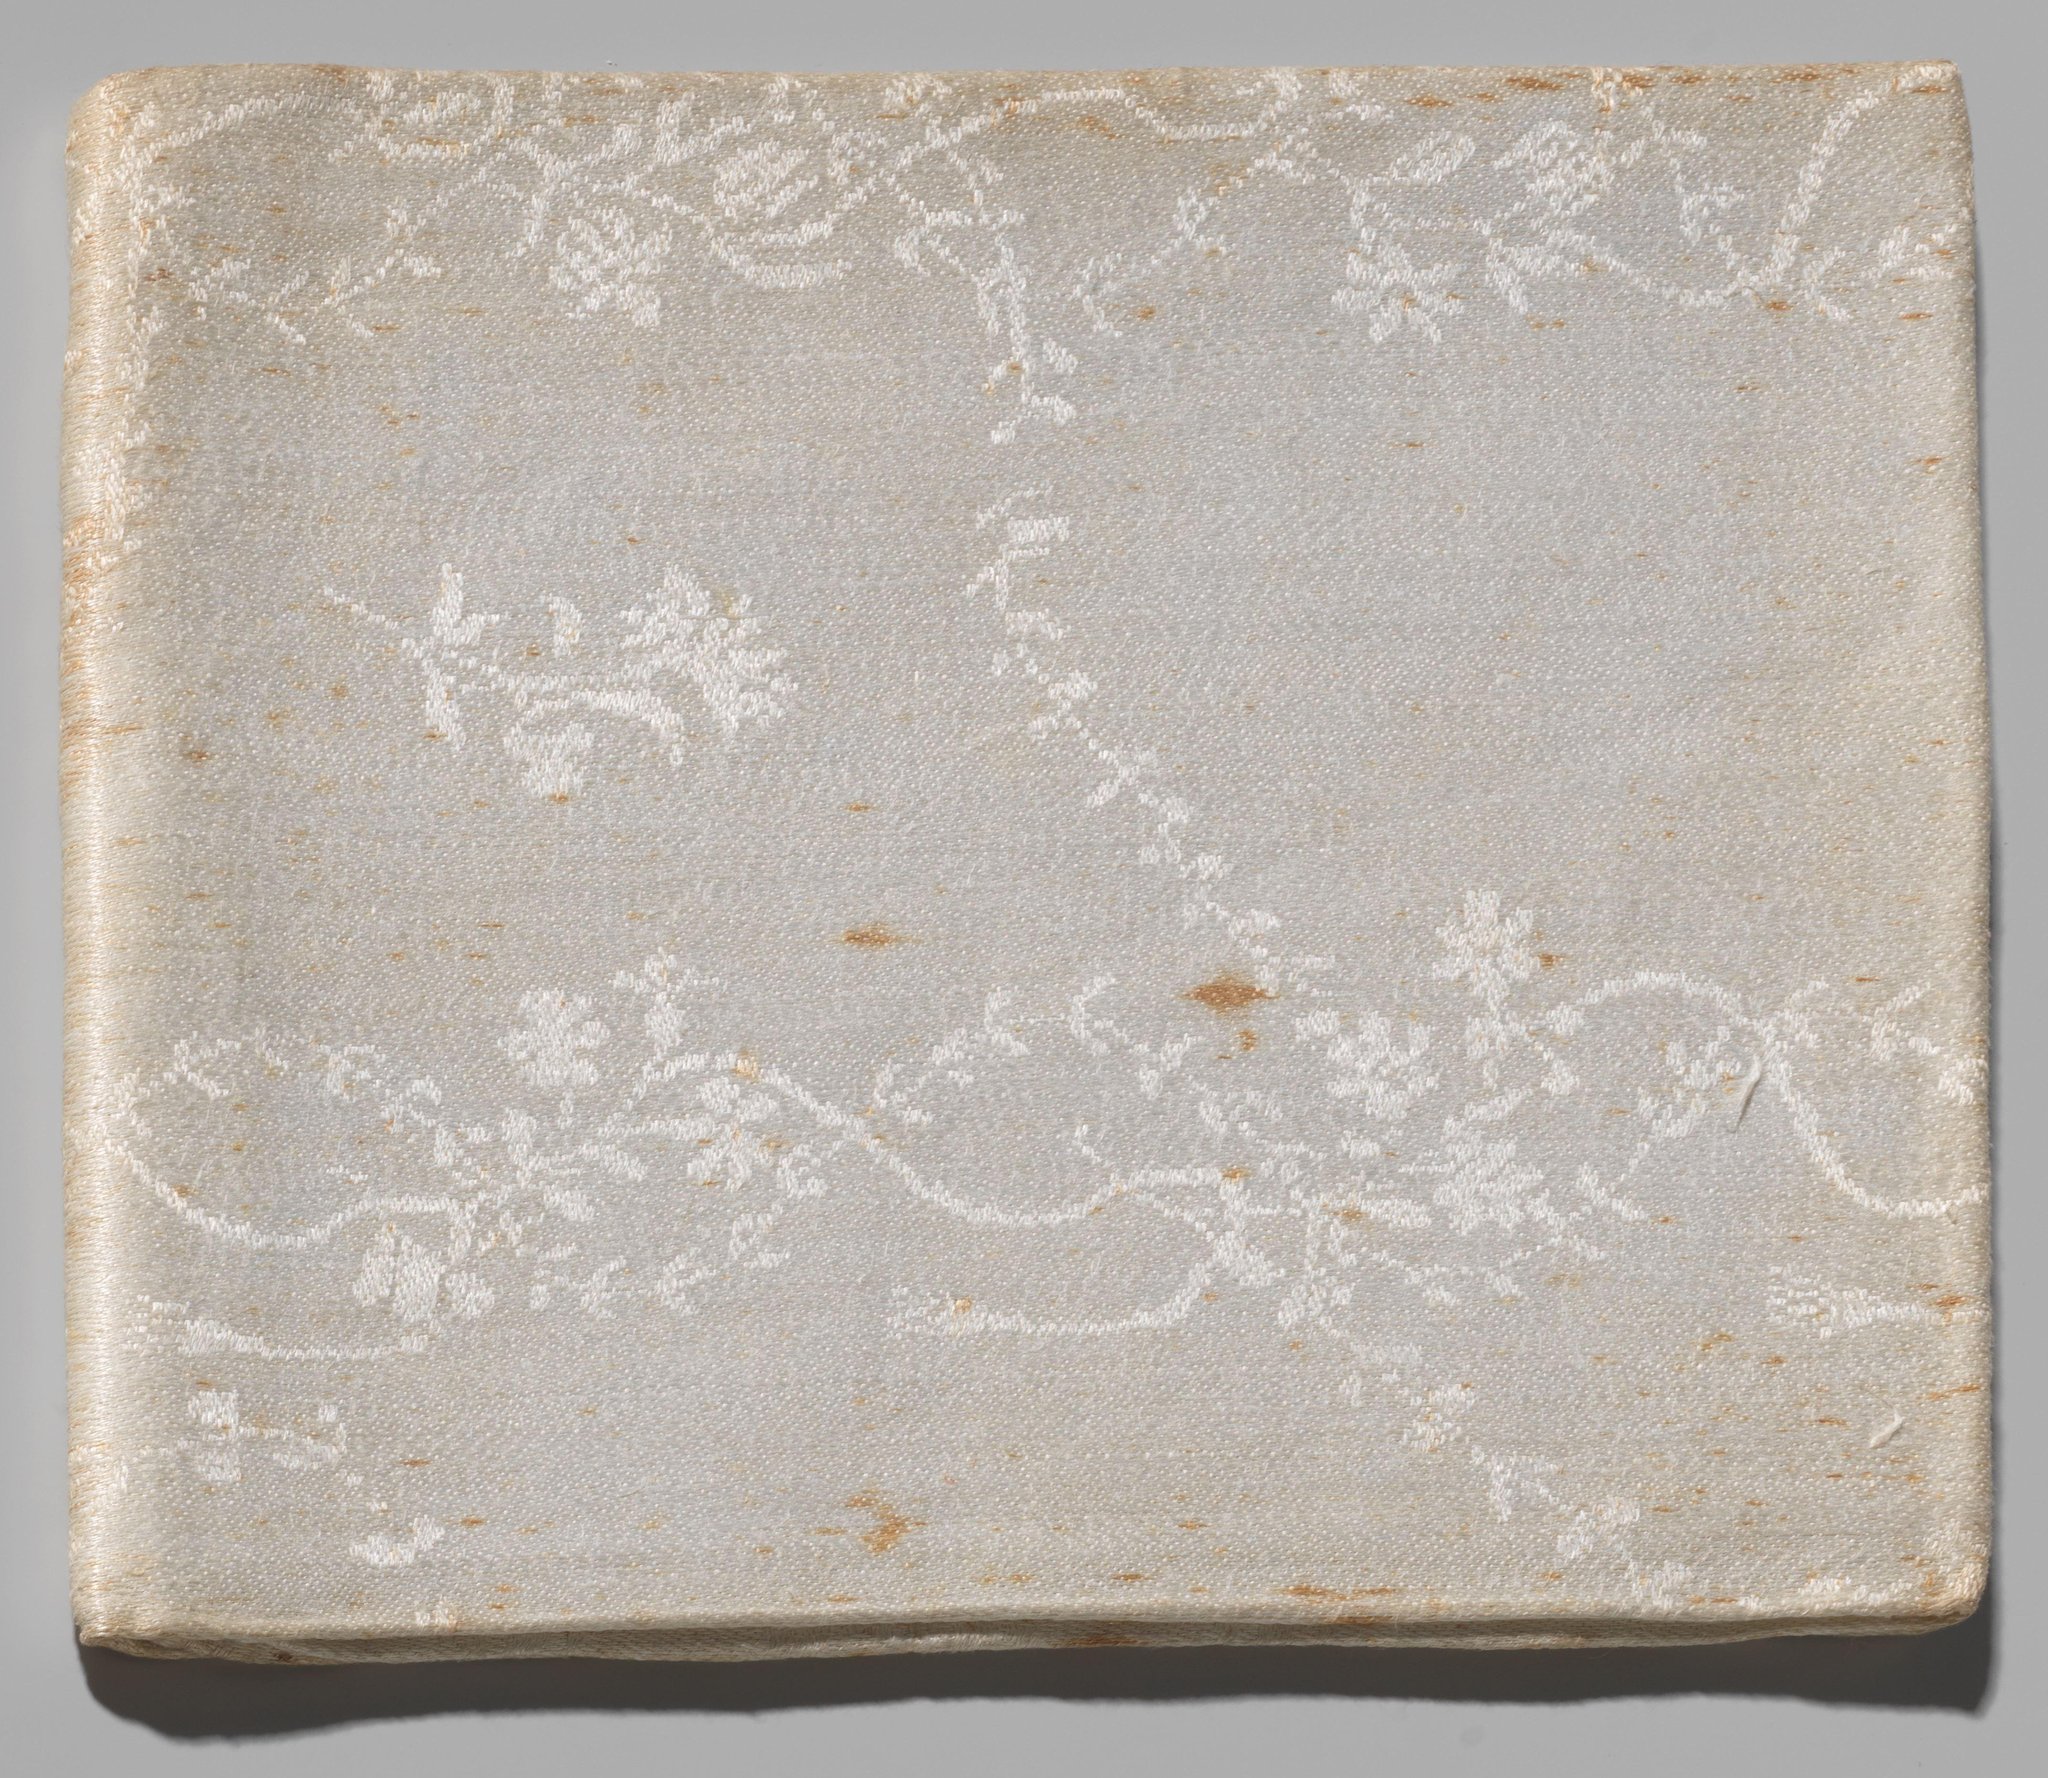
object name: napkin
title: Servet met bloemen en slingers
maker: Anonymous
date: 1800-1810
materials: linen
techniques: damask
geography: brabant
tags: ewout van der hoog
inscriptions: mark: ‘IVDH 24’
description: Servet van linnendamast met bloemen en slingers. Middenveld: een rechtopgaande fijne slingerende tak, met koord en kwast gebonden, wordt door een breed golvende bebladerde tak doorsneden. Randen: driemaal een rechte lijst, spiraalsgewijs omwonden; de middelste is breed en met bladeren omwonden, de buitenste smal en met een fijne bloementak omrankt.